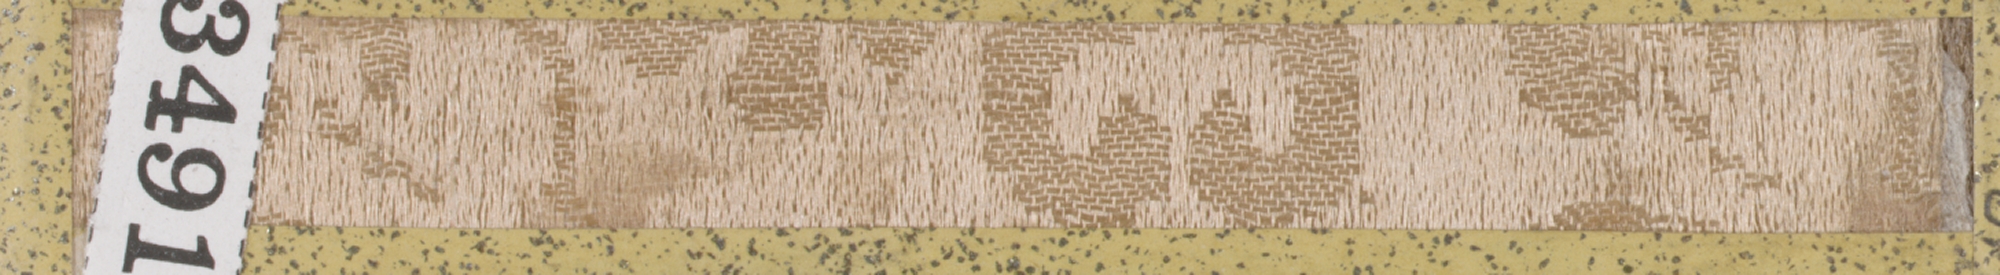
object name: sample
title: Textile Sample from Sample Book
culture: japanese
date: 1801-1900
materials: silk